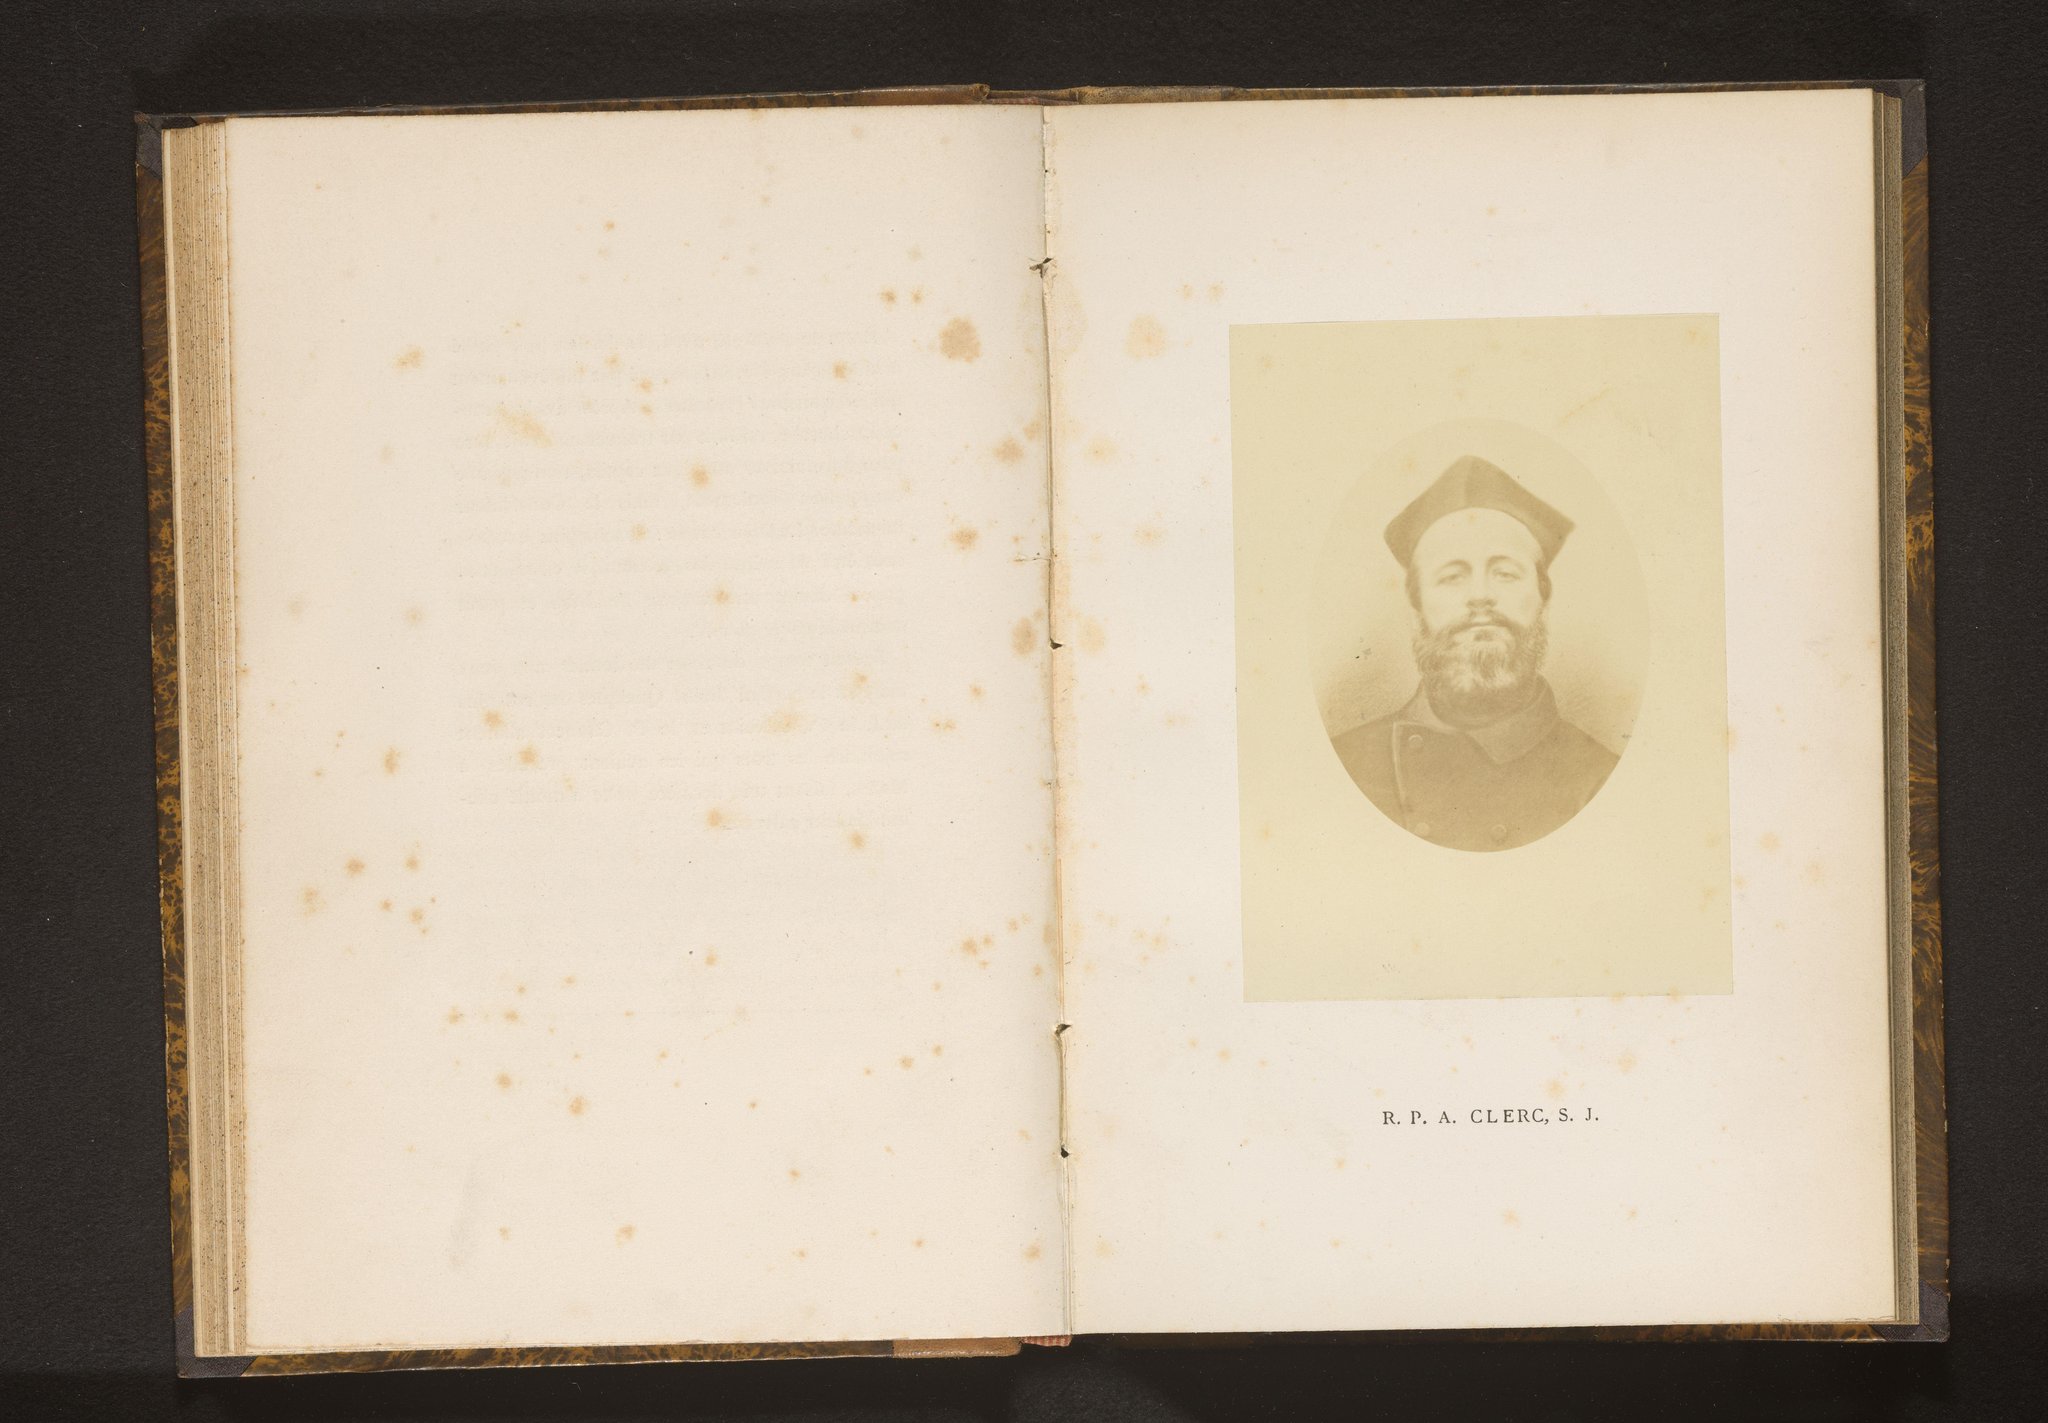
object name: page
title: Portret van Alexis Clerc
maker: Anonymous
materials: photographic support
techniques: albumen print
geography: france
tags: monk(s), friar(s)